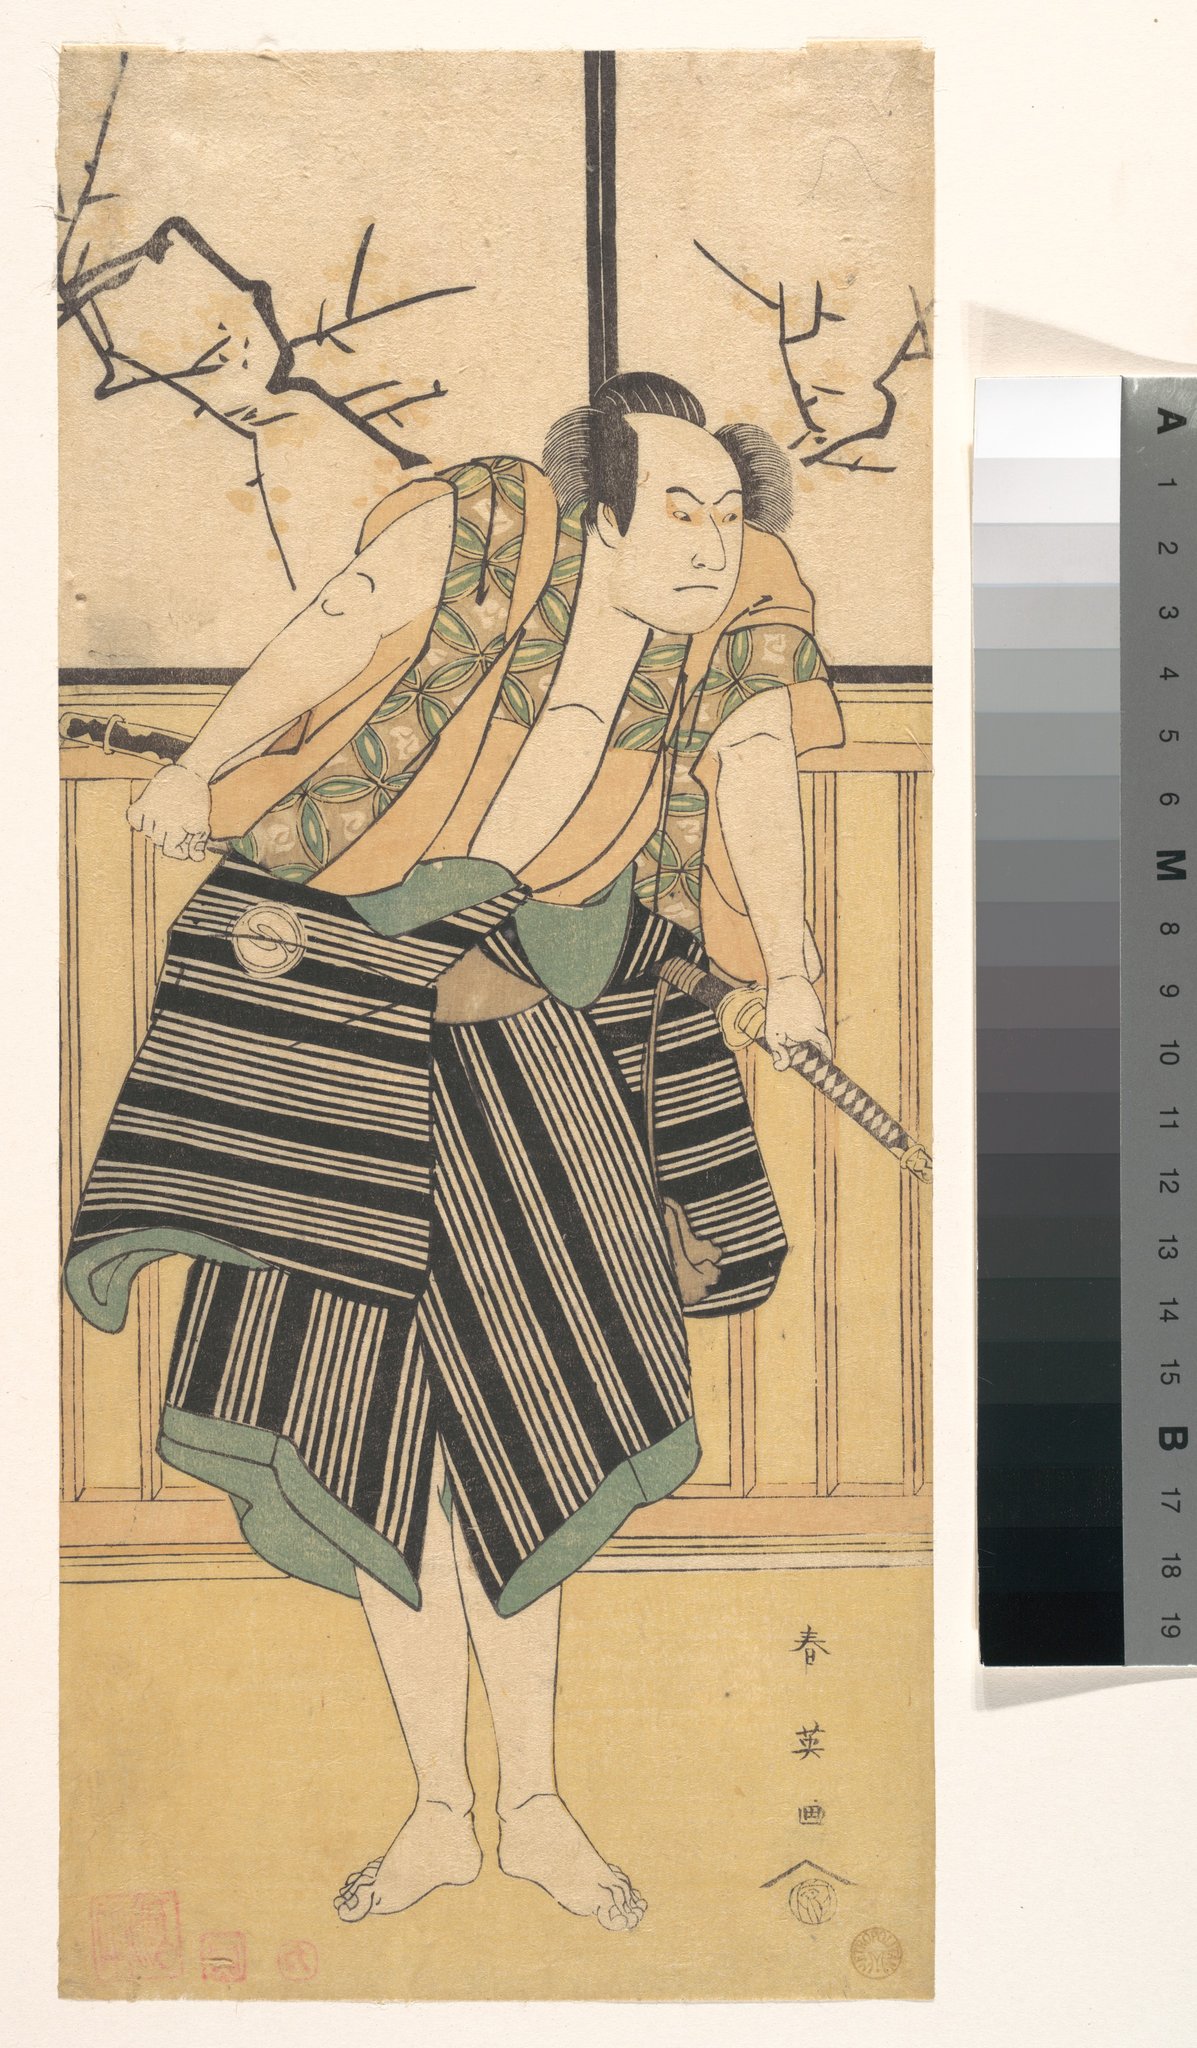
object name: print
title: The Third Sawamura Sojuro as a Man Standing in a Room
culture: japanese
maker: katsukawa shun'ei 勝川春英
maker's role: artist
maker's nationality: japanese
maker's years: 1762-1819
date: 1793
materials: ink, paper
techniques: woodblock print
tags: men,actors